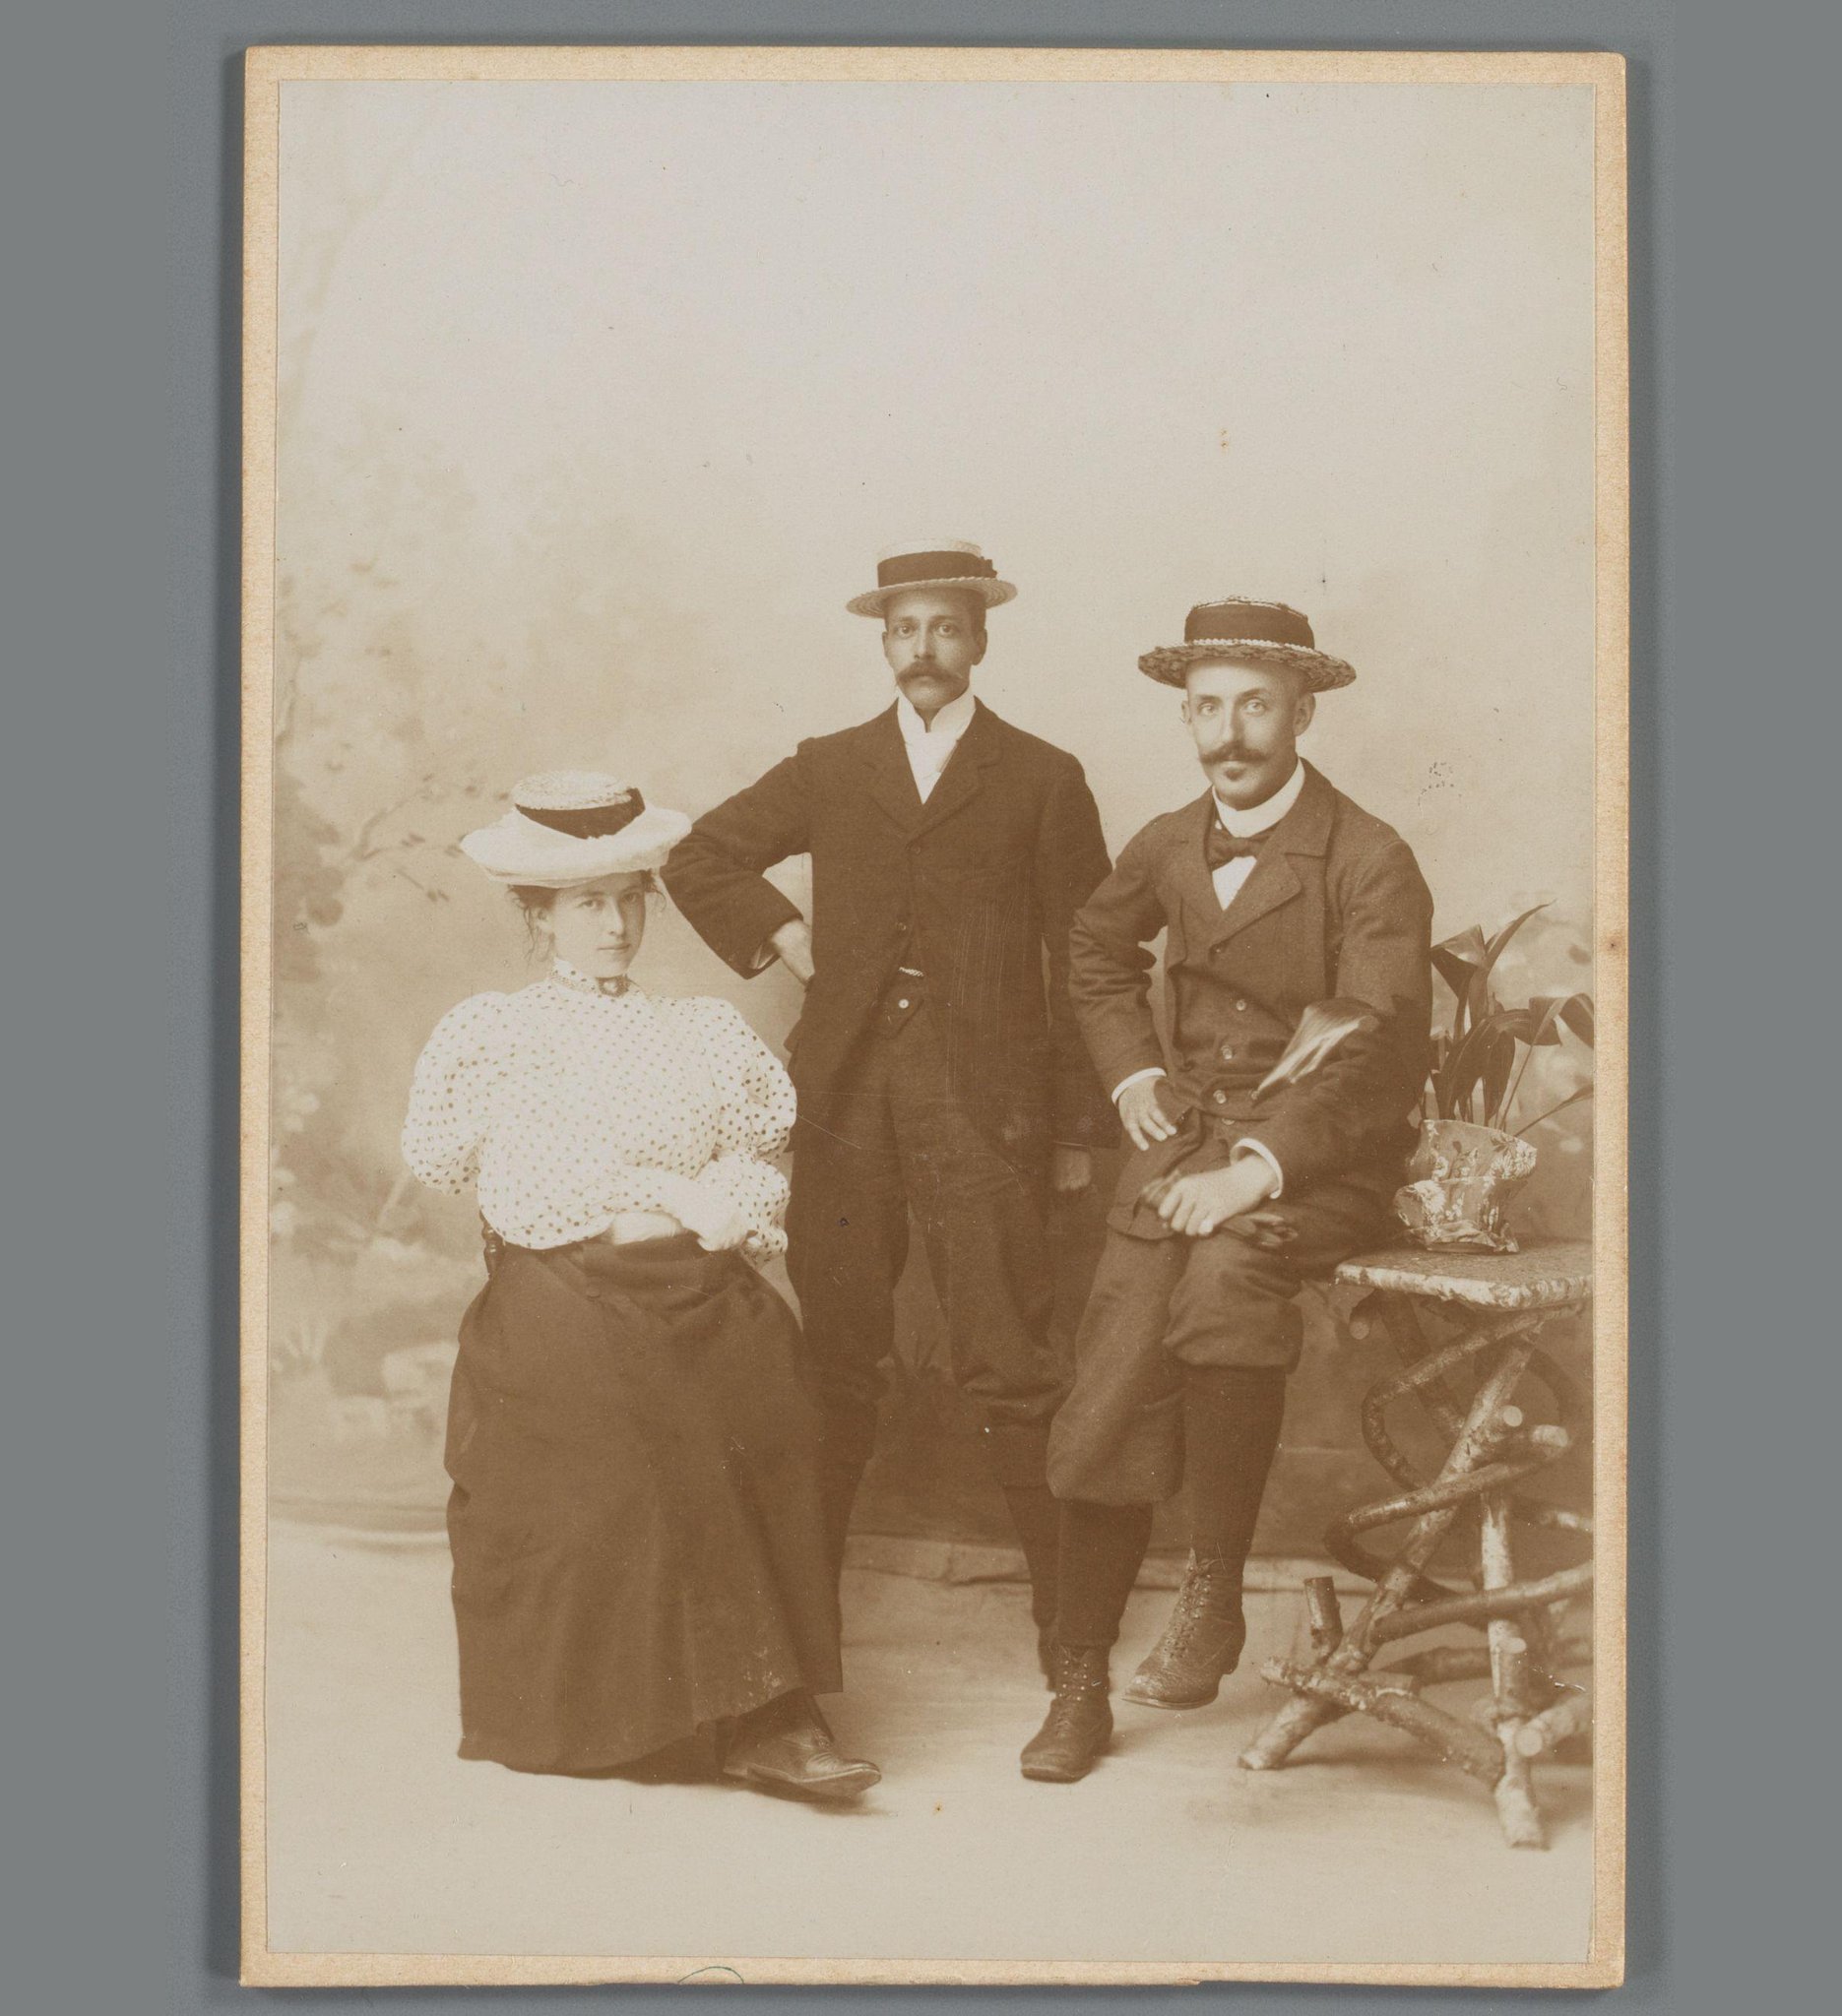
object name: cabinet photograph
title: Groepsportret van twee onbekende mannen en een vrouw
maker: Anonymous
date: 1897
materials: paper, cardboard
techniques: collodion silver print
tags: anonymous historical persons portrayed in a group, in a group-portrait